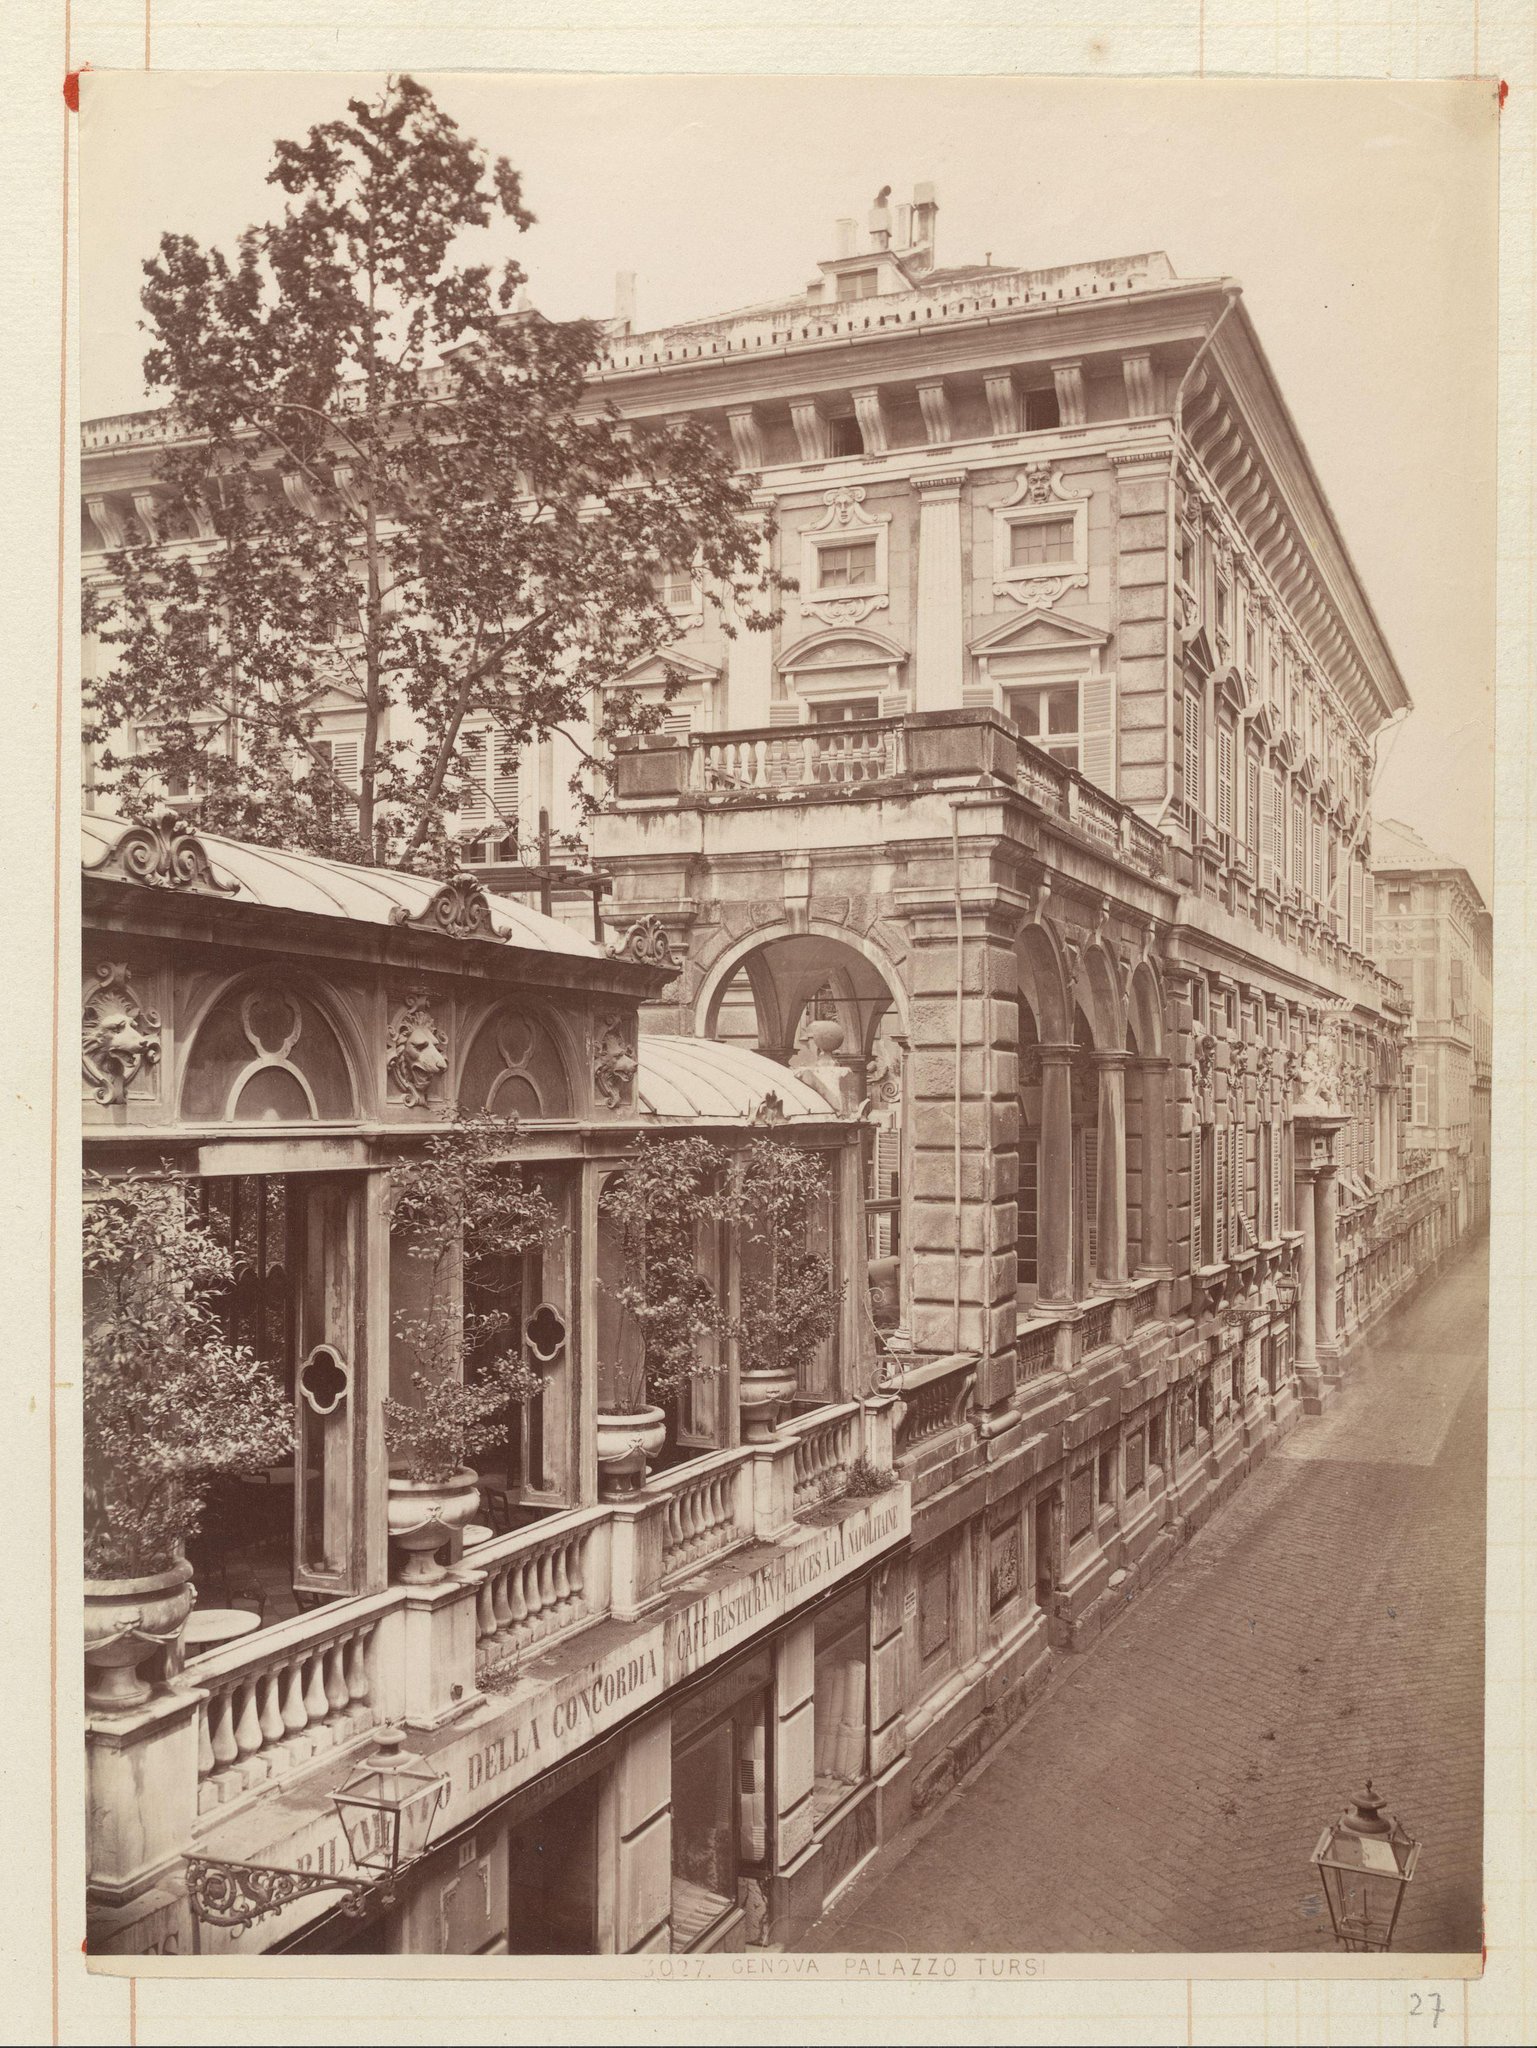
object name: photograph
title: Exterieur van het Palazzo Doria-Tursi te Genua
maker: Anonymous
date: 1880-1900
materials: lacquer, paper, photographic support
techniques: albumen print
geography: genoa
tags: palace